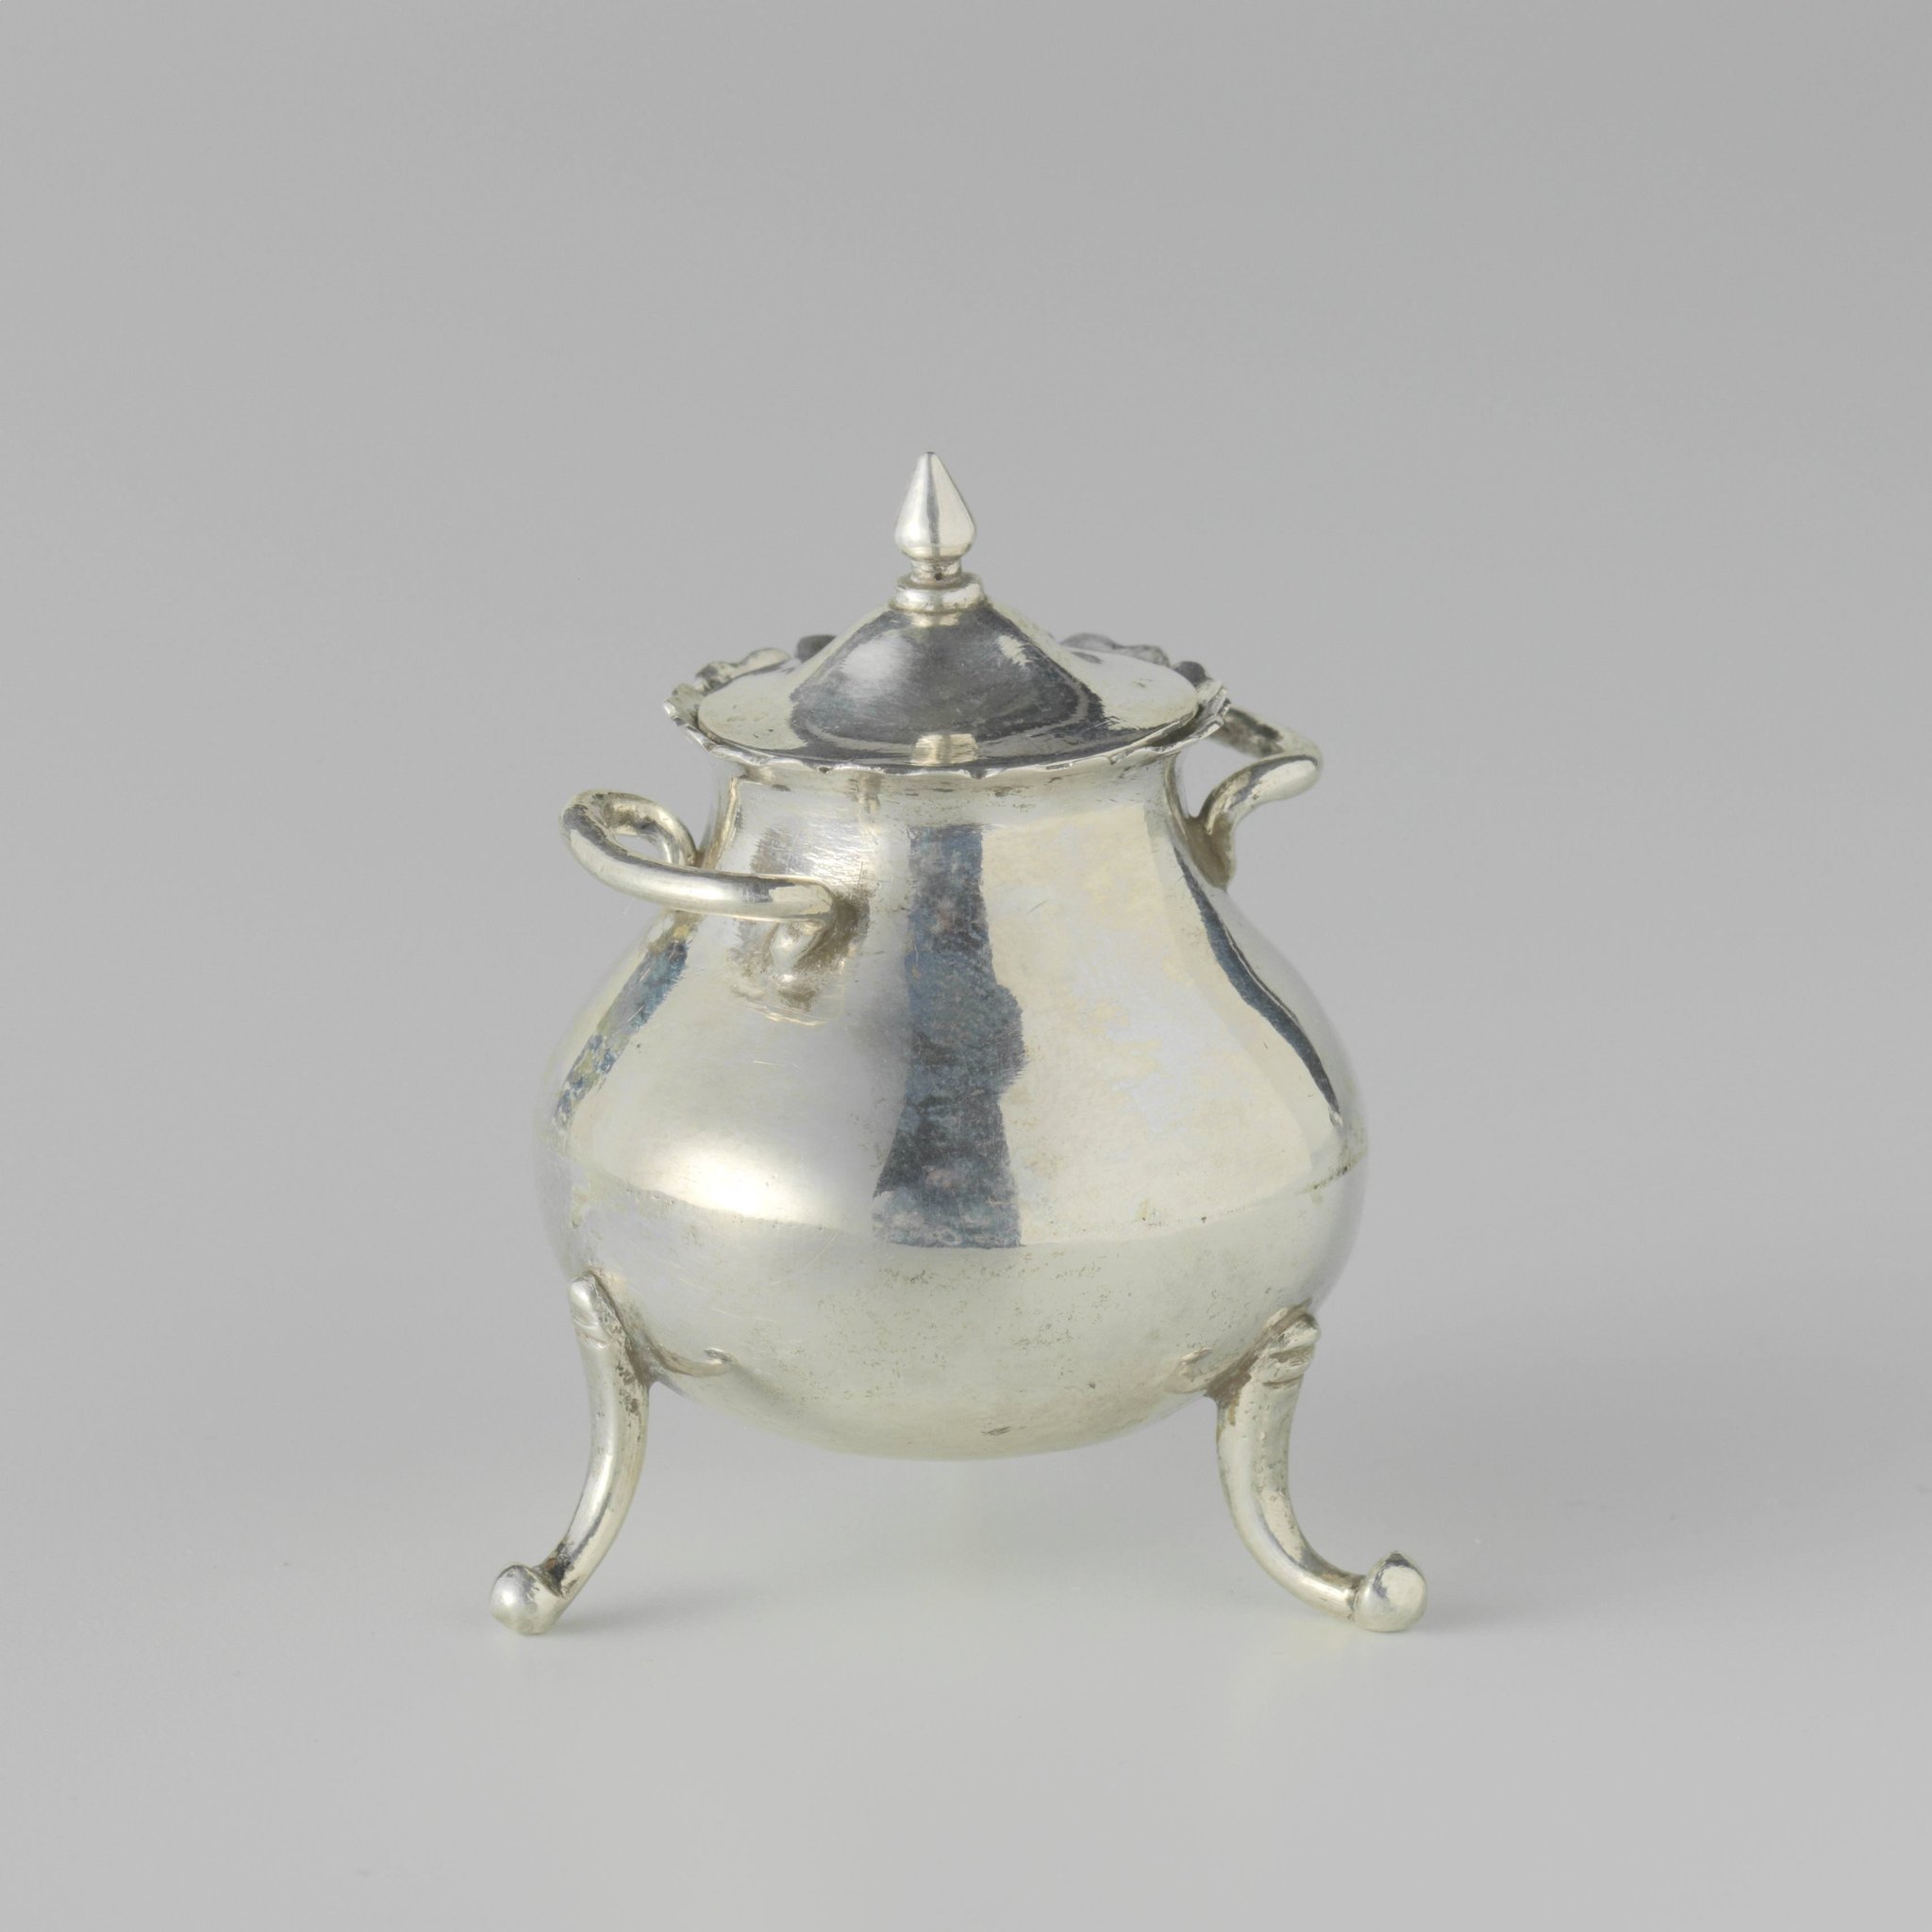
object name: miniature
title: Suikerpot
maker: Anonymous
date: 1770-1800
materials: silver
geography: netherlands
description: Peervormige suikerpot op drie hoge, naar buiten gebogen poten, die eindigen in een bol. Het deksel is gewelfd en heeft een puntige knop. De pot heeft twee handvatten. De bovenrand van de pot is gekarteld. De suikerpot is gemerkt met een onleesbaar merk en een bijltje.